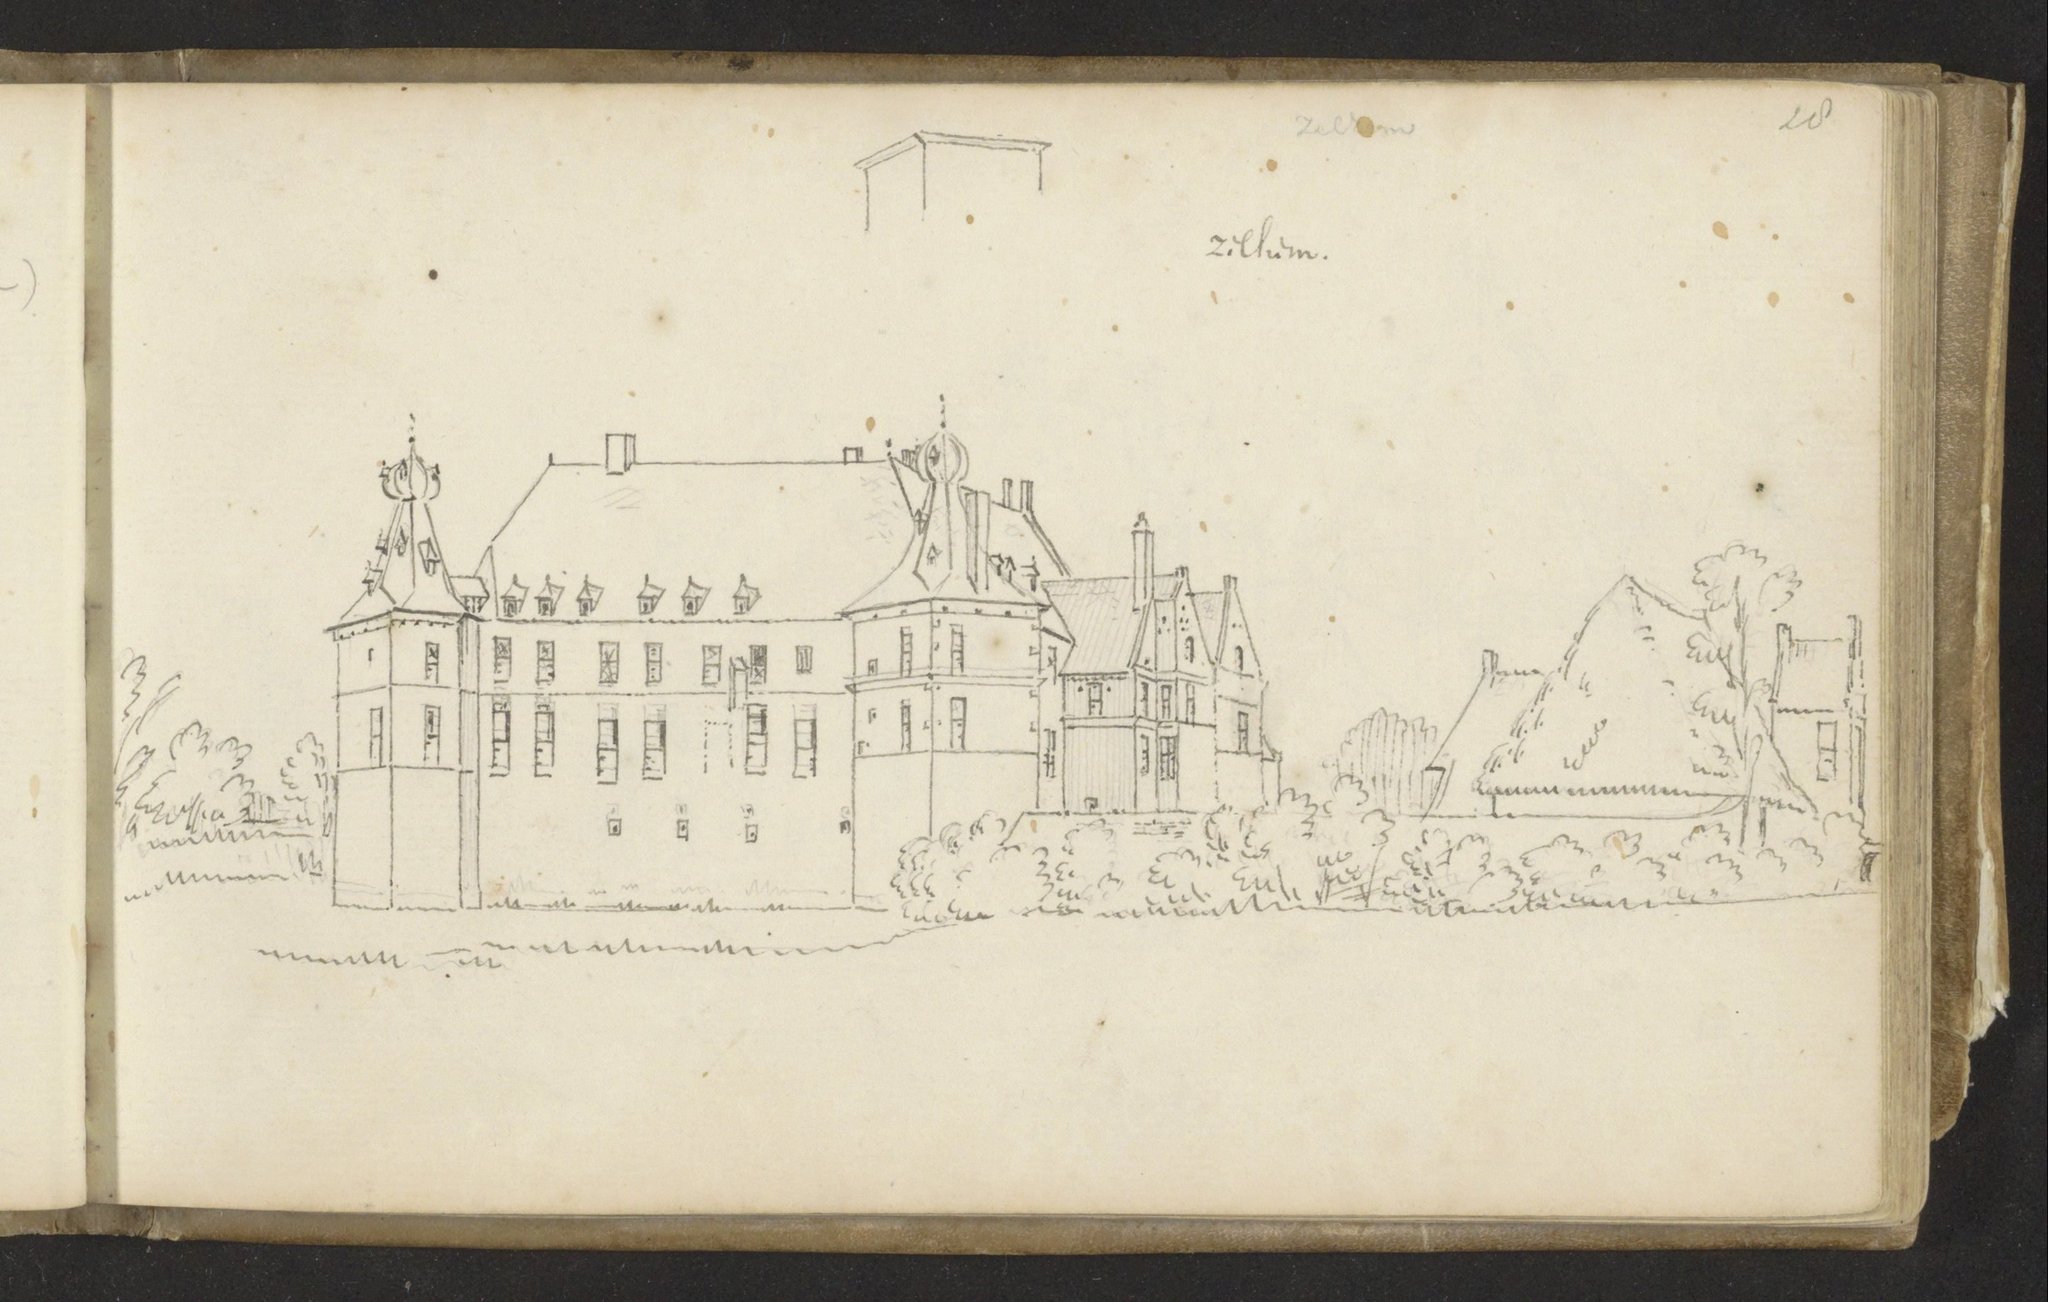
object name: sketchbook leaf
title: Burcht Zelhem nabij Mehr te Duitsland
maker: abraham de haen (ii)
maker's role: draughtsman, print maker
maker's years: 1707-1748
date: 1731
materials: ink, paper, pencil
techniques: pen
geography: mehr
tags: castle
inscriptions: annotation: ‘Zelhem/ Zilhim’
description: Blad 28 recto uit een schetsboek met 69 bladen.